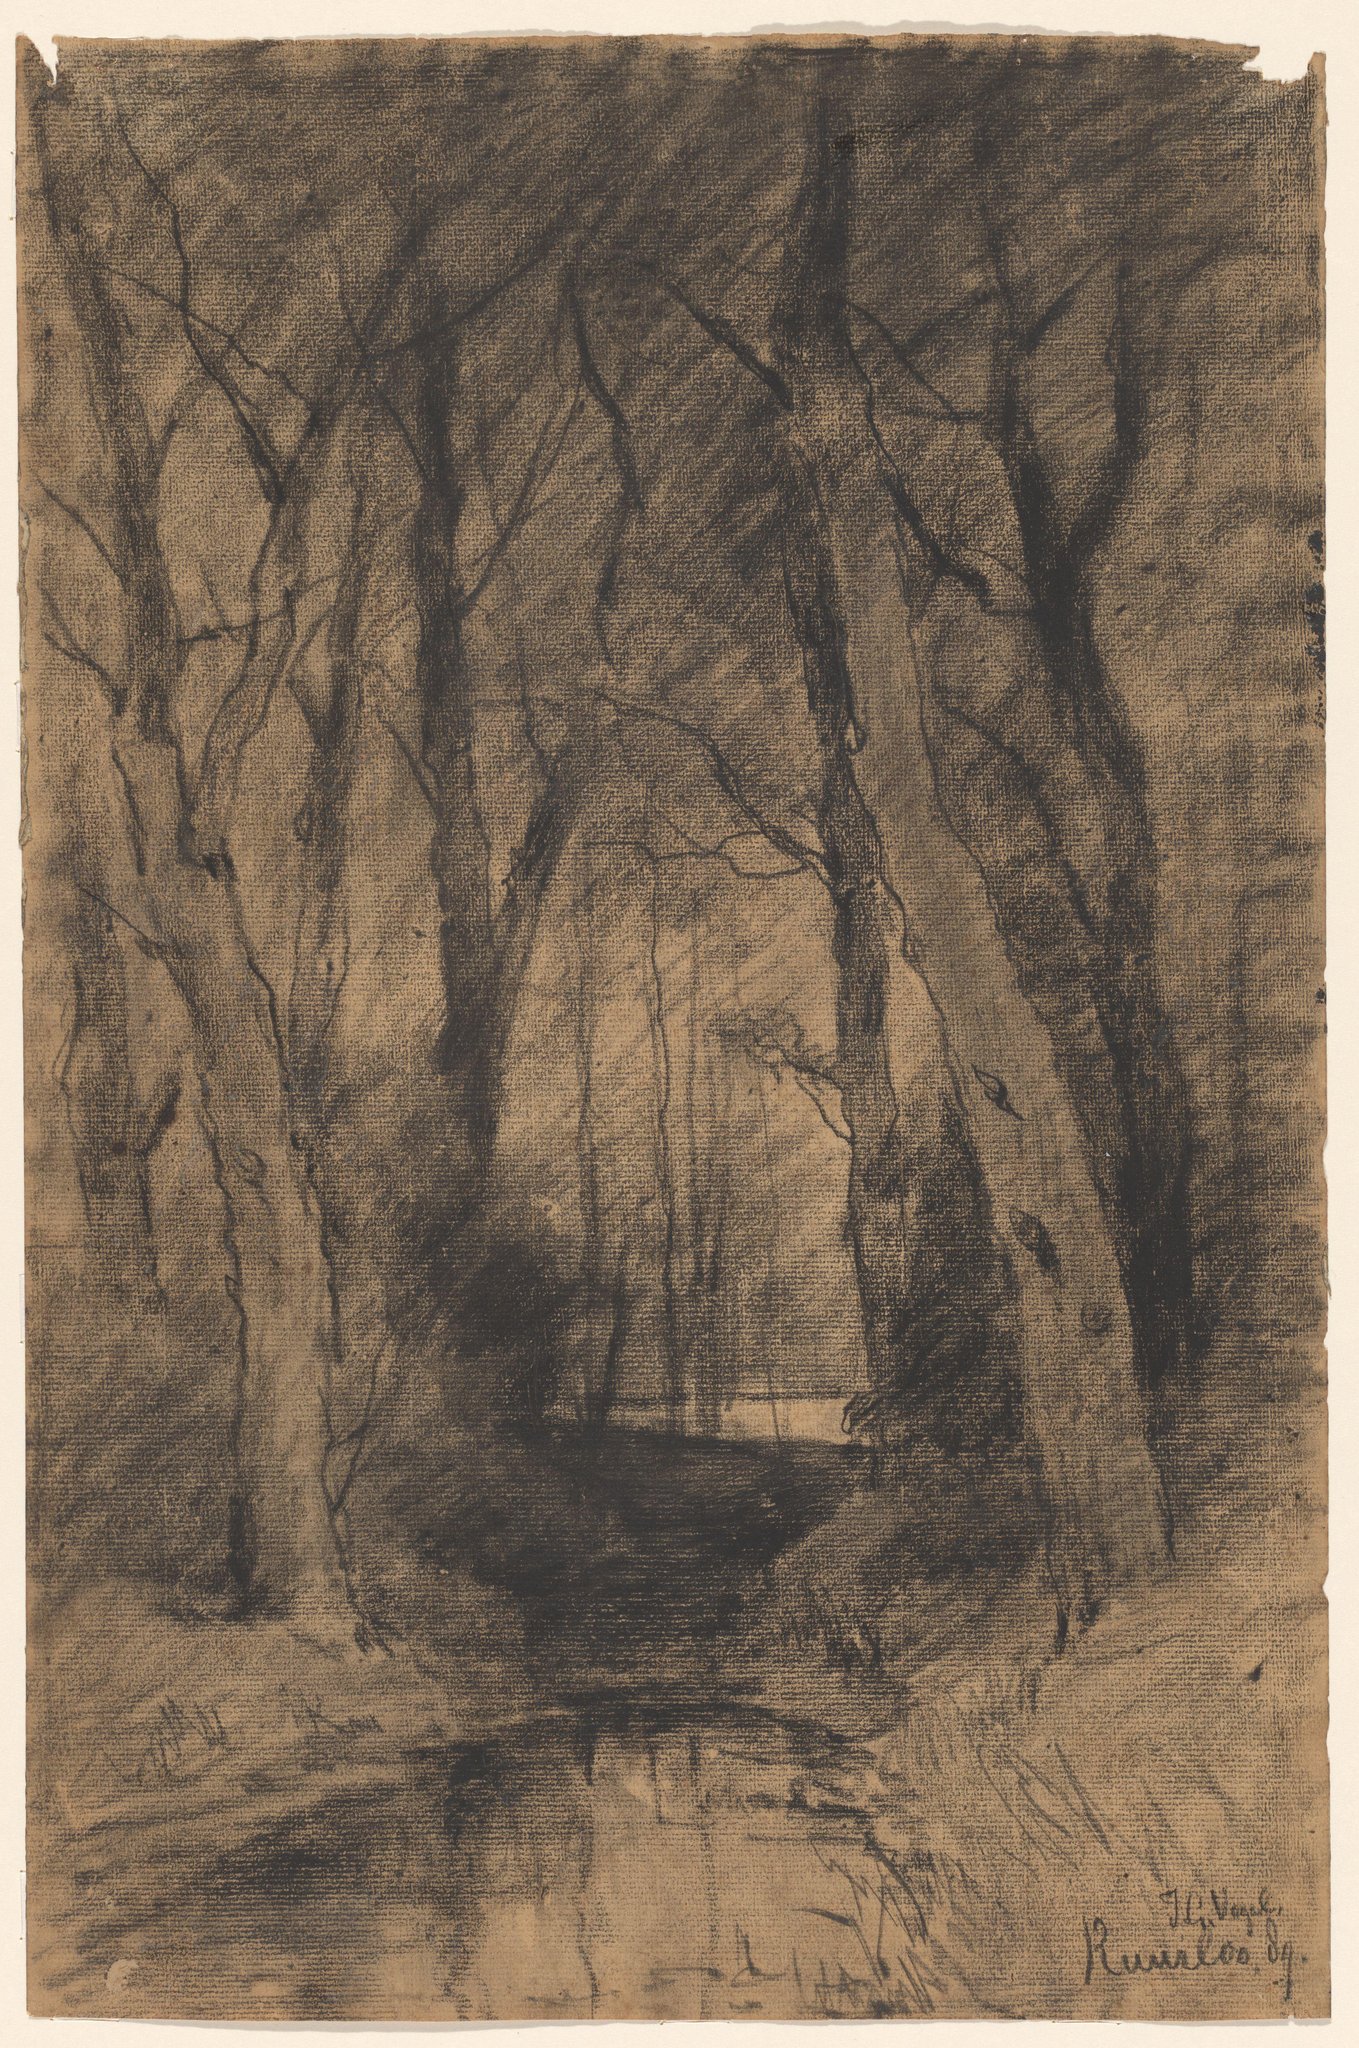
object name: drawing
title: Bomen te Ruurlo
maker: johannes gijsbert vogel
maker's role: draughtsman, painter, print maker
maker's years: 1828-1915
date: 1889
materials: chalk, paper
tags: trees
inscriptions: collector's mark: Lugt 1181b, date and inscription: ‘Ruurlo '89.’